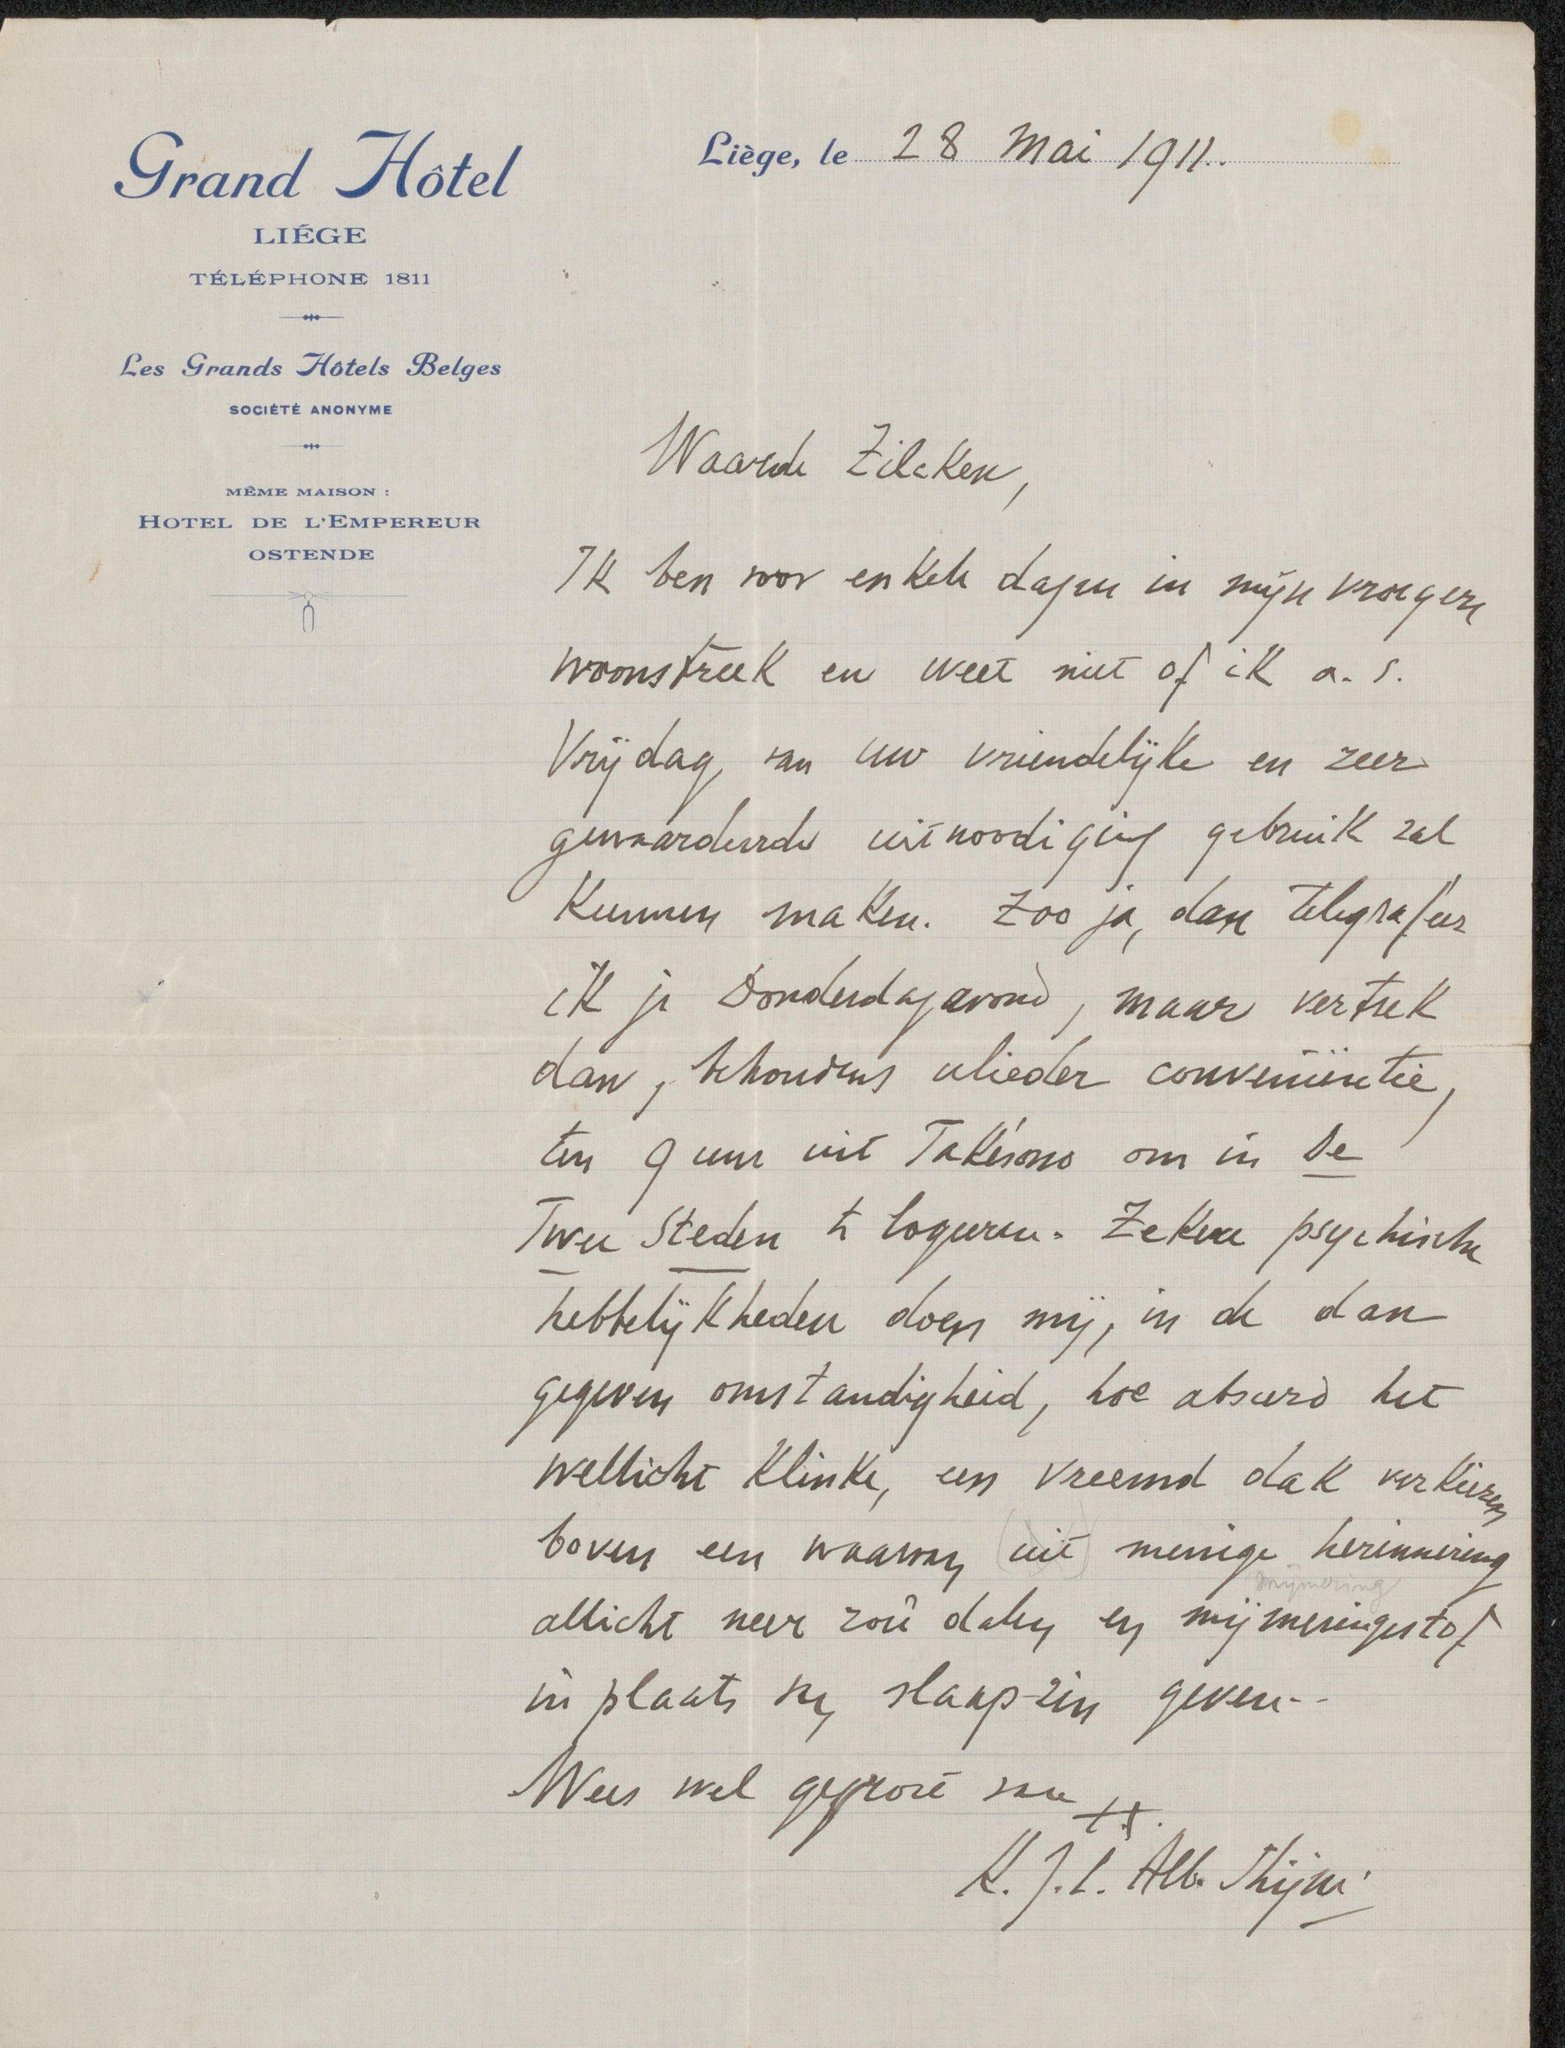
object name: letter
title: Brief aan Philip Zilcken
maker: karel johan lodewijk alberdingk thijm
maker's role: criticus, prozaschrijver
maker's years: 1864-1952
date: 1911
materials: ink, paper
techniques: pen, printing, writing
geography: liège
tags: the hague, painter, draughtsman, philip zilcken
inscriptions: collector's mark: ‘RPK’